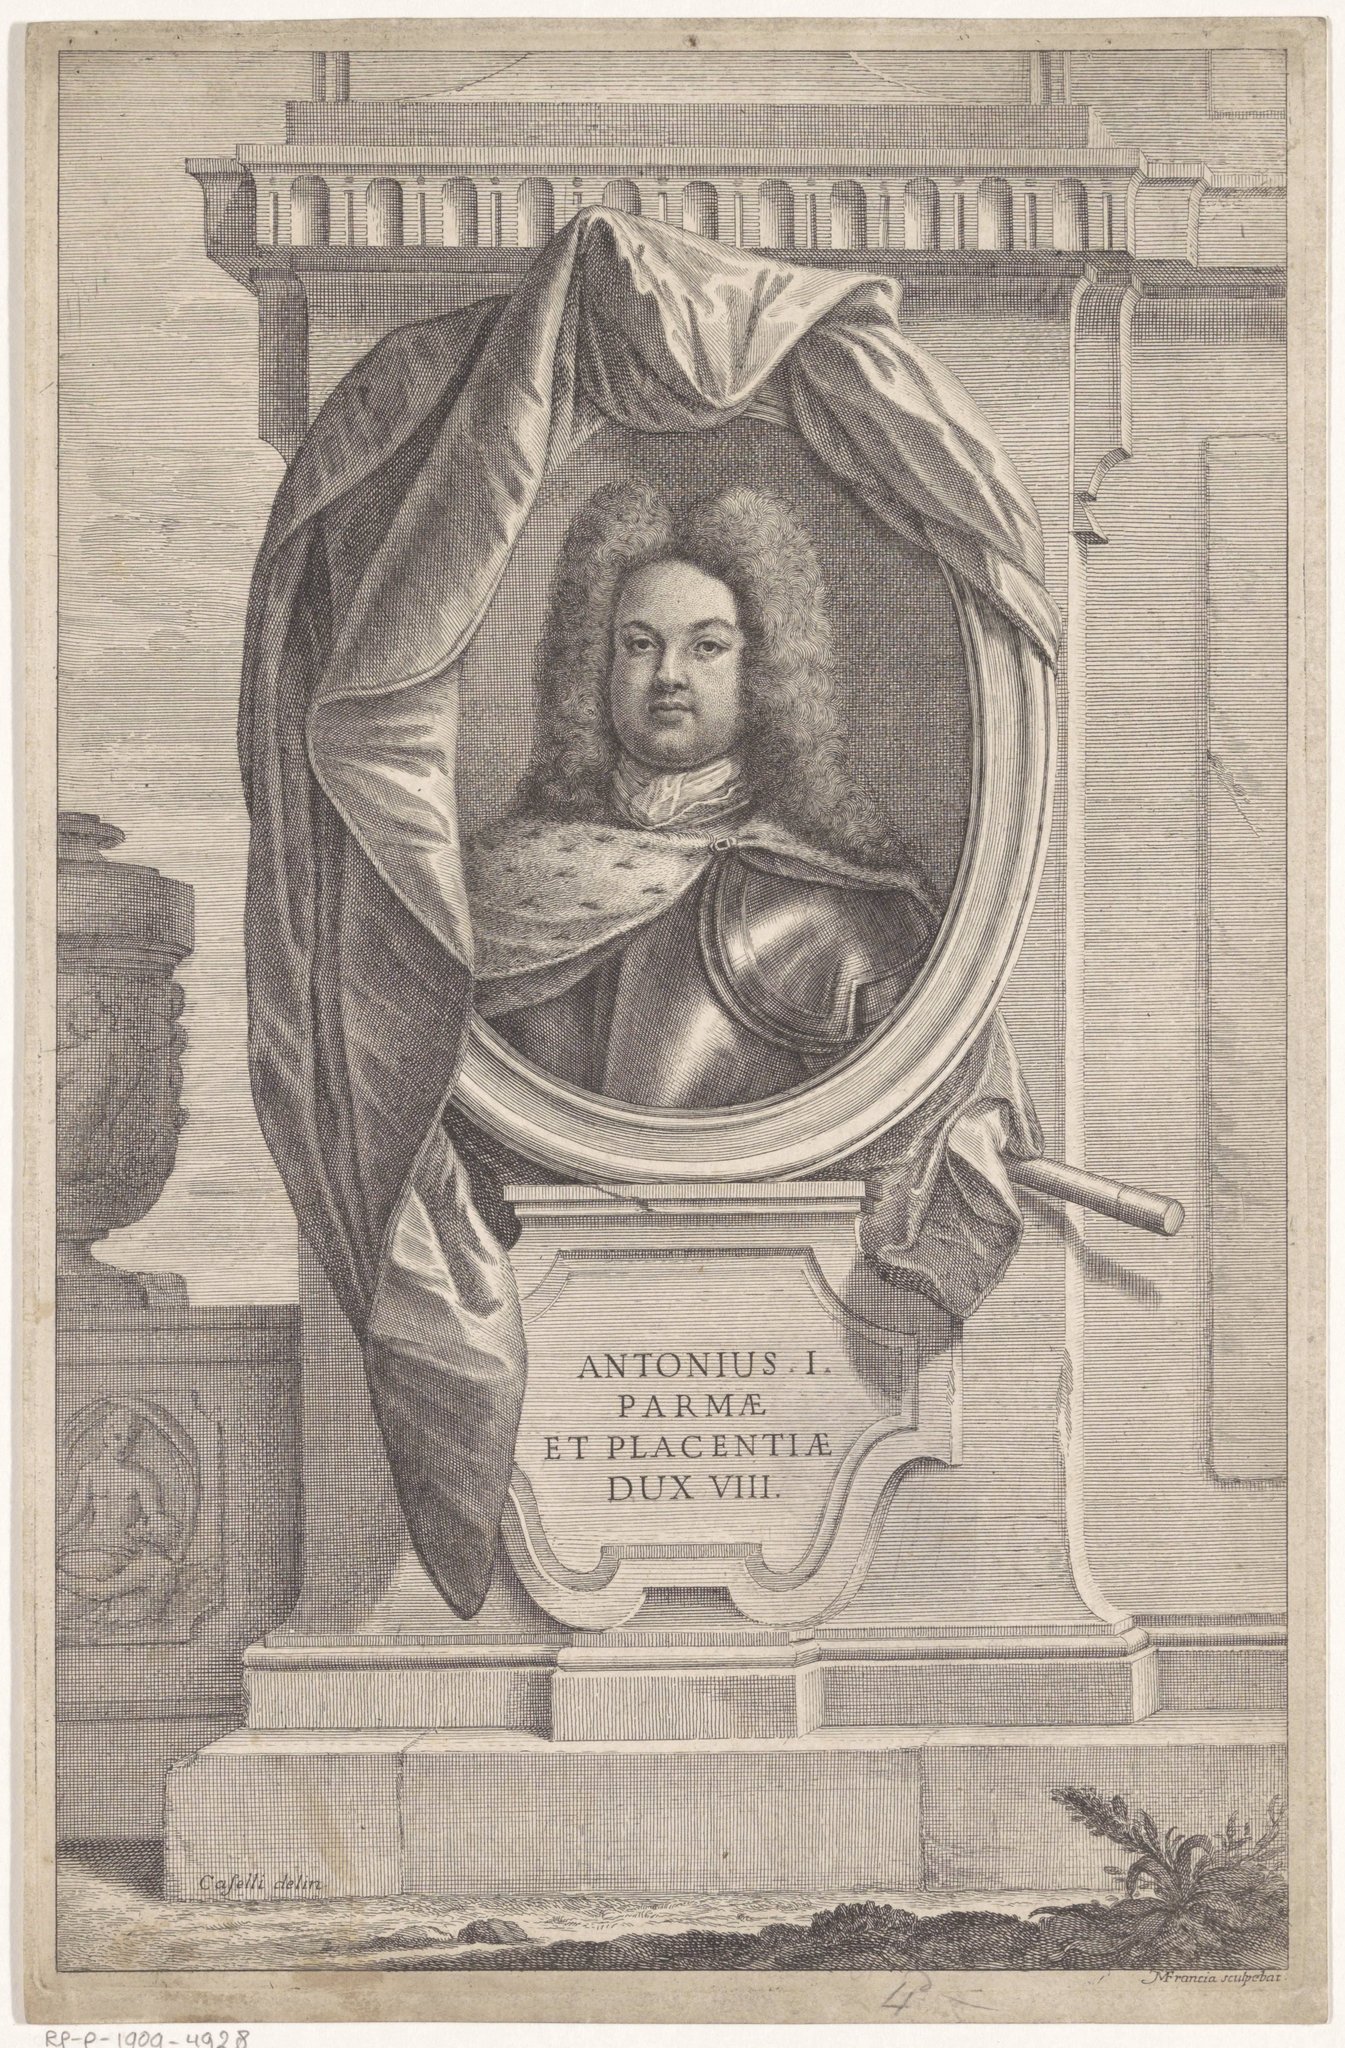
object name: print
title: Portret van Antonio Farnese, hertog van Parma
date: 1667-1735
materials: paper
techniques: etching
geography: italy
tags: historical persons, ruler, sovereign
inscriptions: collector's mark: Lugt 2228